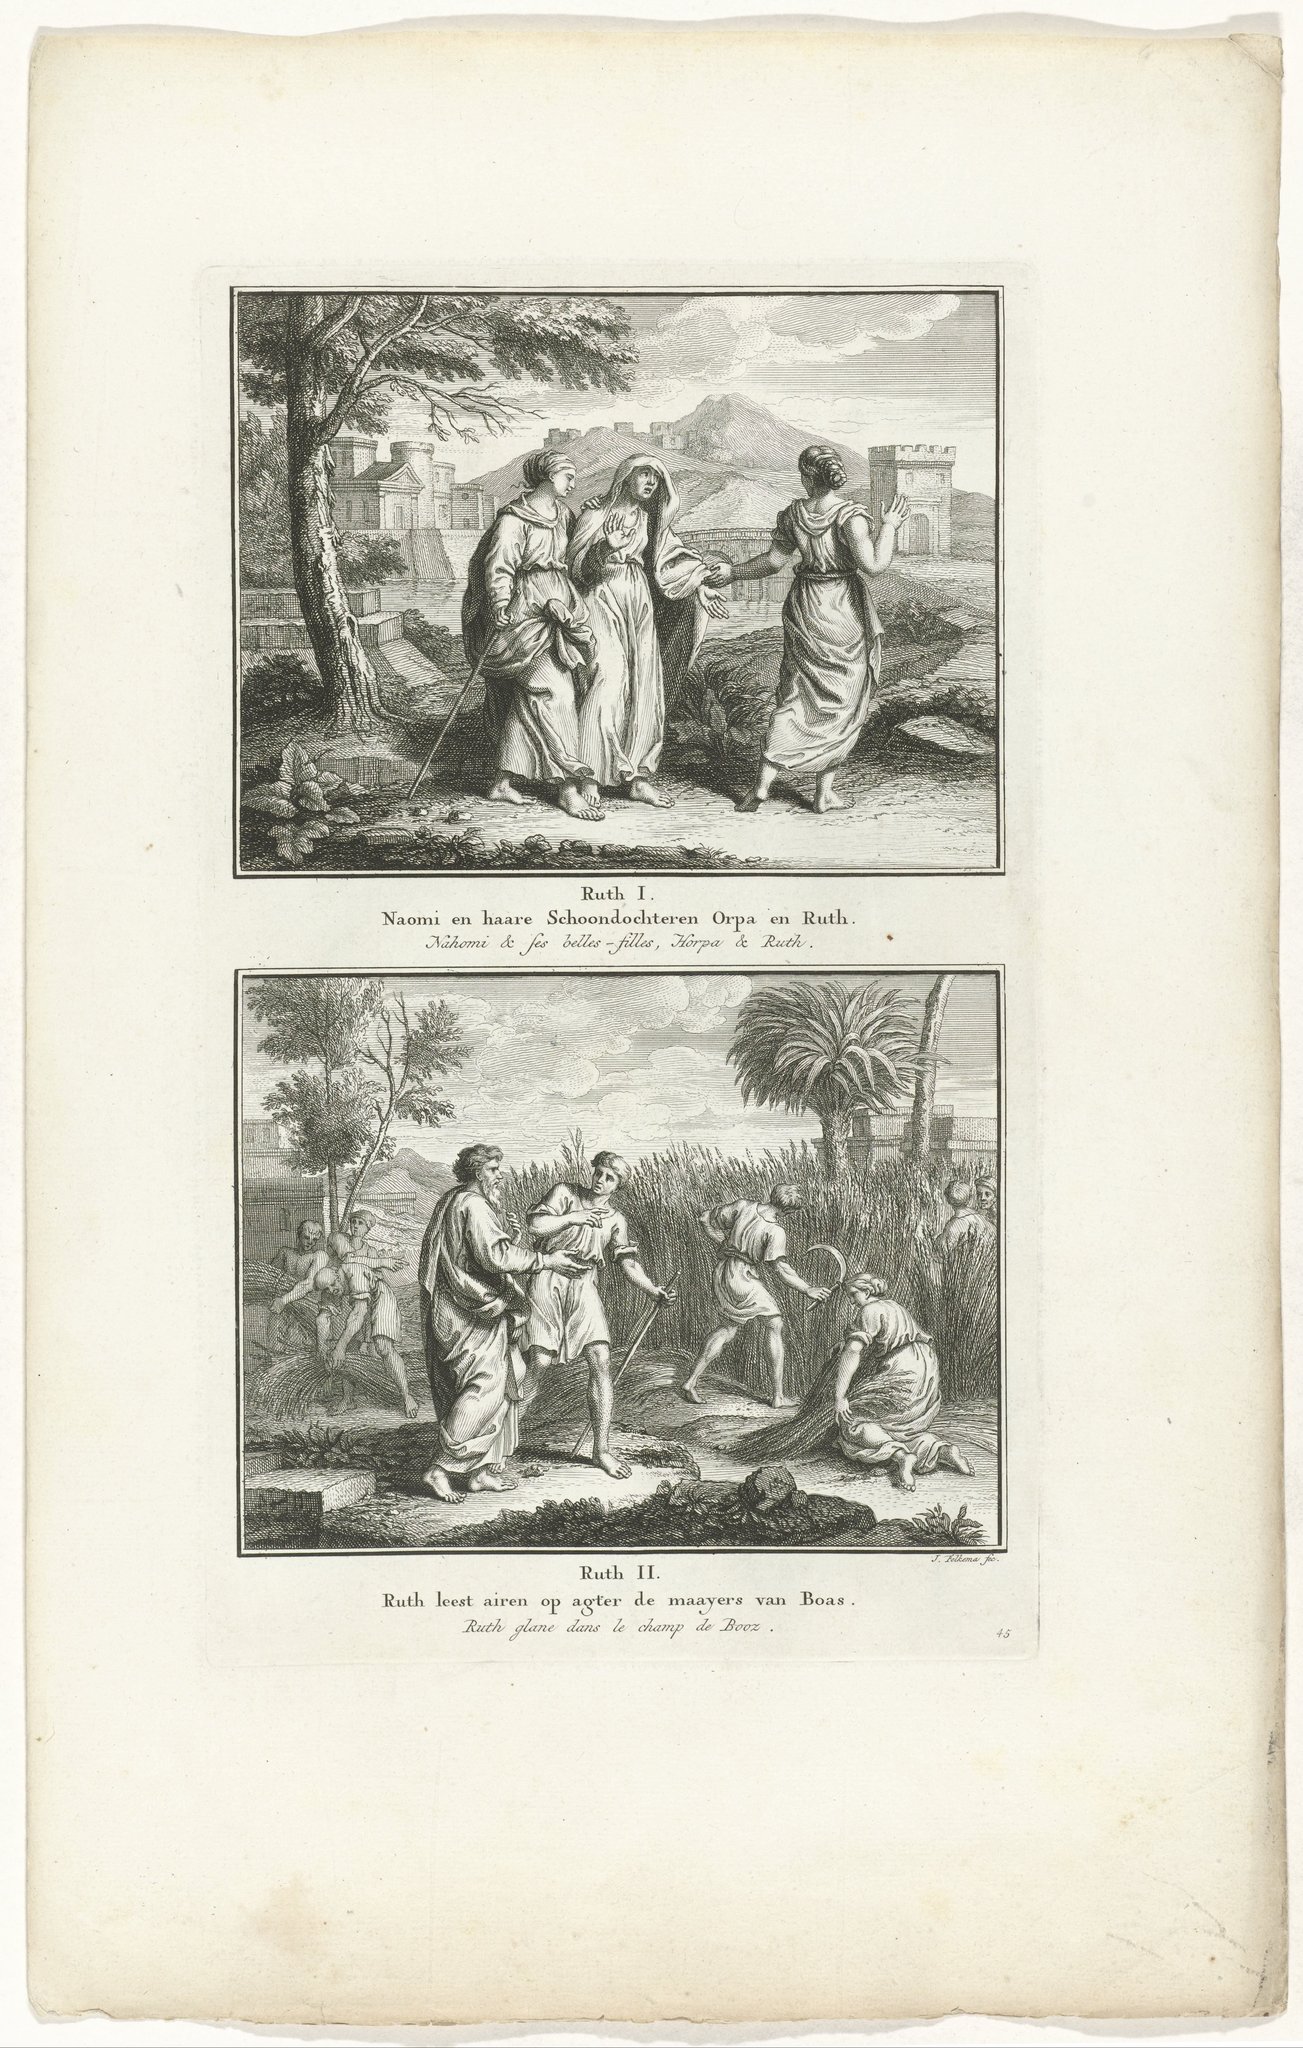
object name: print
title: Naomi met haar schoondochters Orpa en Ruth en Ruth leest aren op het land van Boaz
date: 1791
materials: paper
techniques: etching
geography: dordrecht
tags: ruth gleaning, naomi on her way to bethlehem with her daughters-in-law, orpah and ruth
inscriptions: collector's mark: Lugt 2233, collector's mark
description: Illustratie uit: Hamelsveld, Ysbrand van. De gewigtigste geschiedenissen des Bybels, afgebeeld in twee honderd twee en vijftig printverbeeldingen (...) met eene zaaklijke uitbreiding opgehelderd. Amsterdam / Dordrecht: Jan de Groot / Abraham en Pieter Blussé.